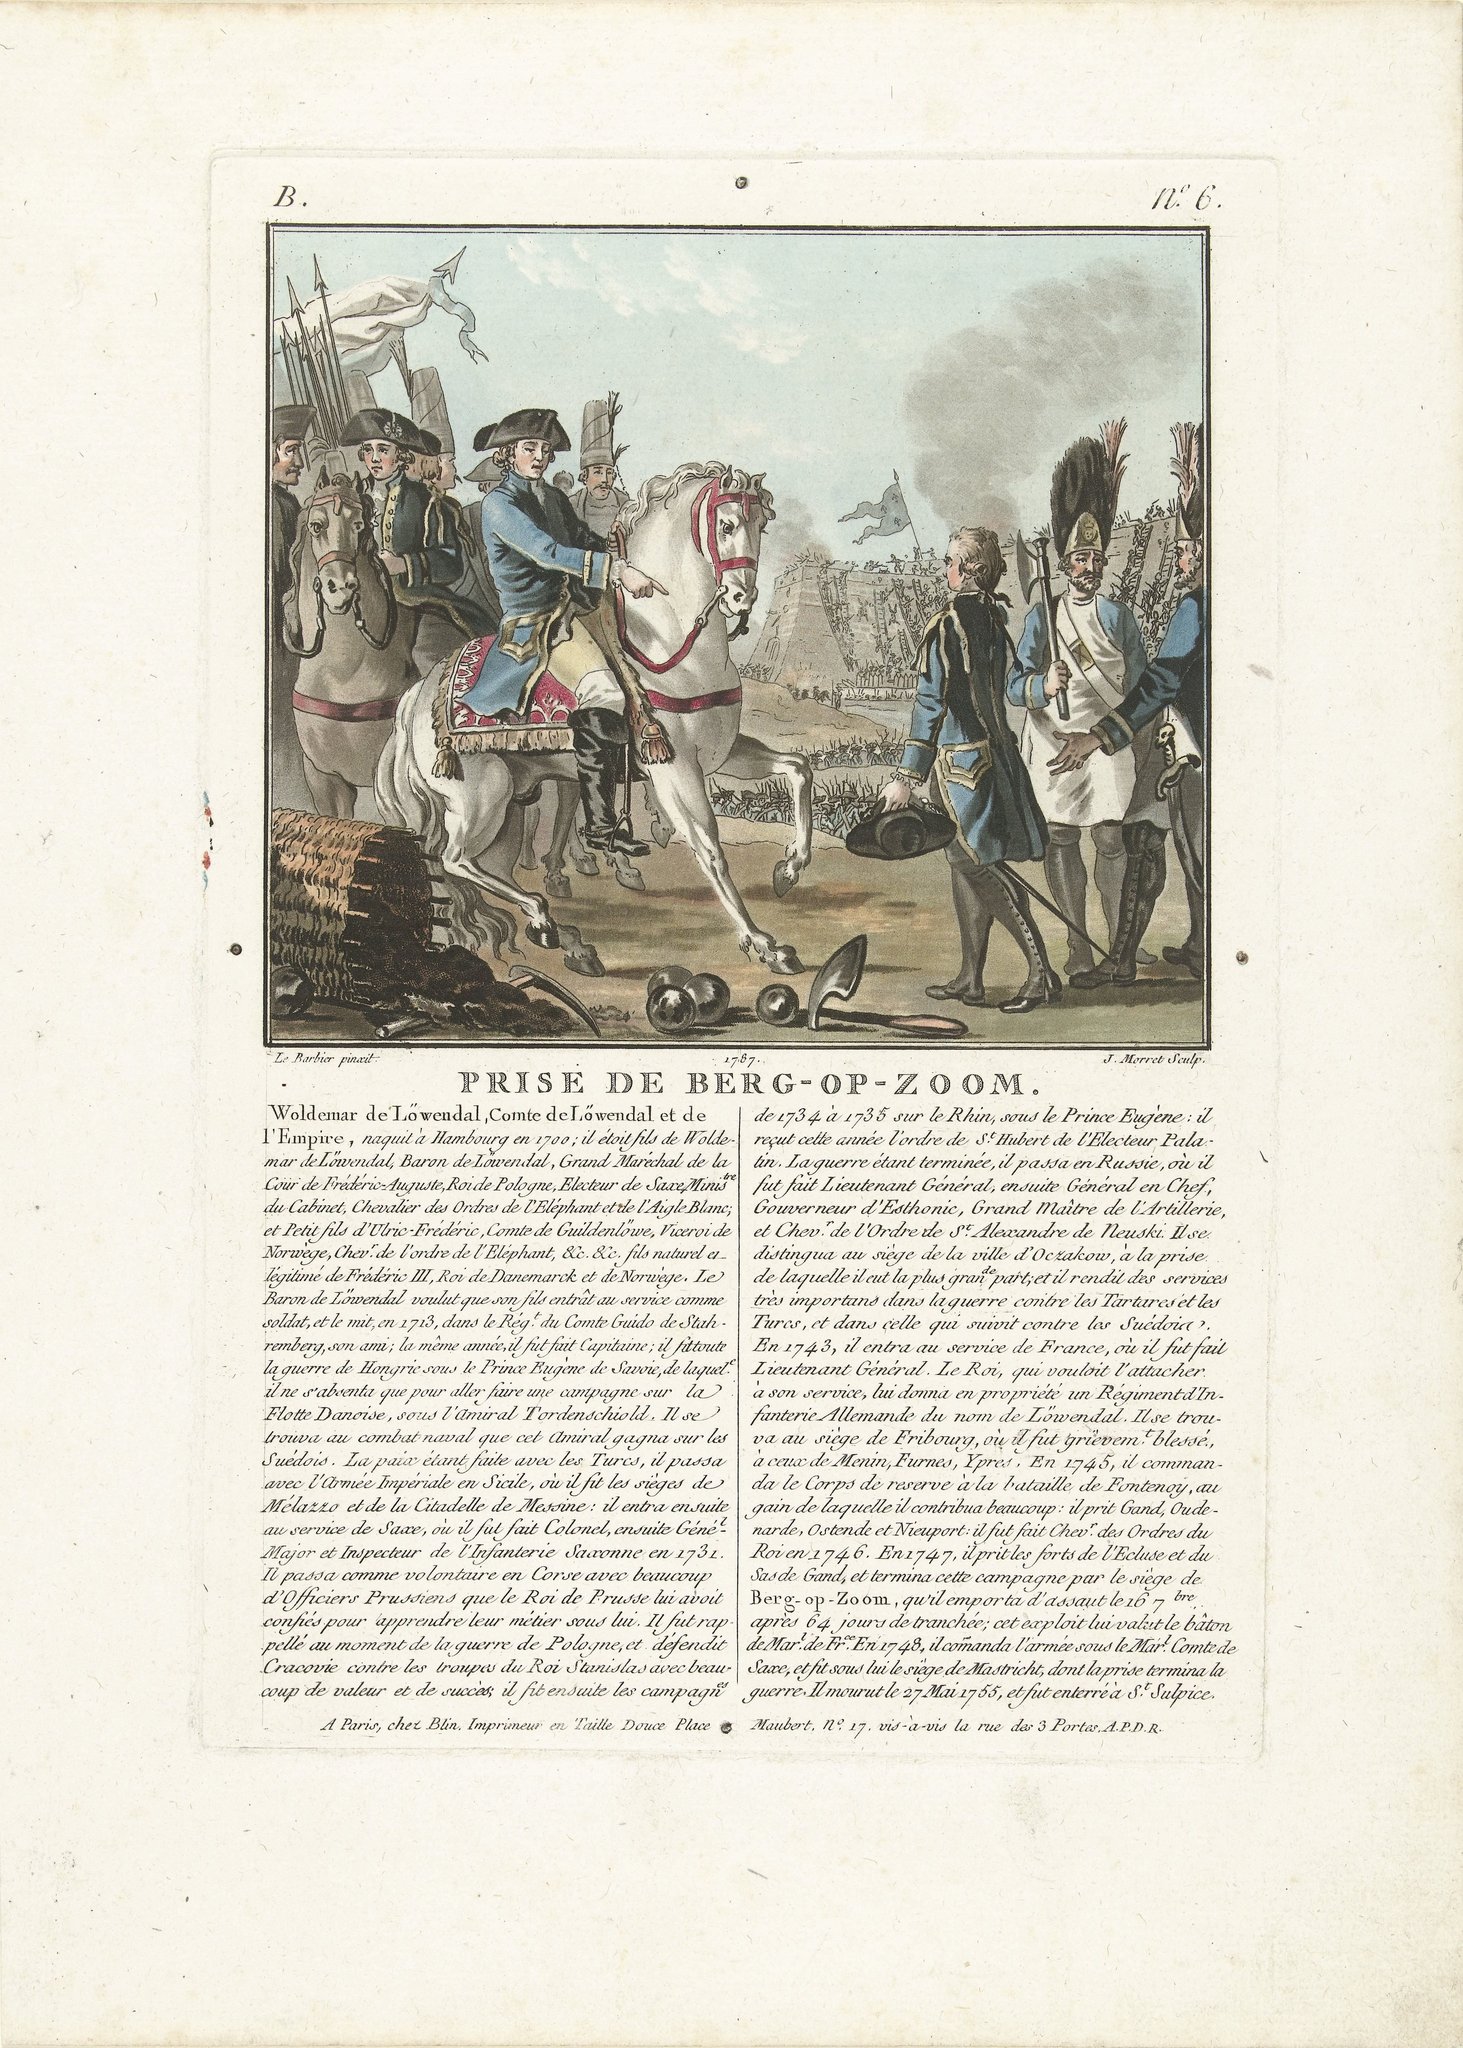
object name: print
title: Inname van Bergen op Zoom in 1747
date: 1787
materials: paper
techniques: engraving, etching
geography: paris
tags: paris, siege, position war, bergen op zoom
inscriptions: collector's mark: Lugt 2228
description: Inname van Bergen op Zoom door het Franse leger onder maarschalk Lowendal, 16 september 1747. Lowendal te paard tussen enkele officieren, op de achtergrond de bestorming van de muren van de stad. In het onderschrift een lange beschrijving van de loopbaan van de maarschalk tot aan zijn dood in 1755, in twee kolommen in het Frans. Gemerkt linksboven: B. en rechtsboven: No. 6.